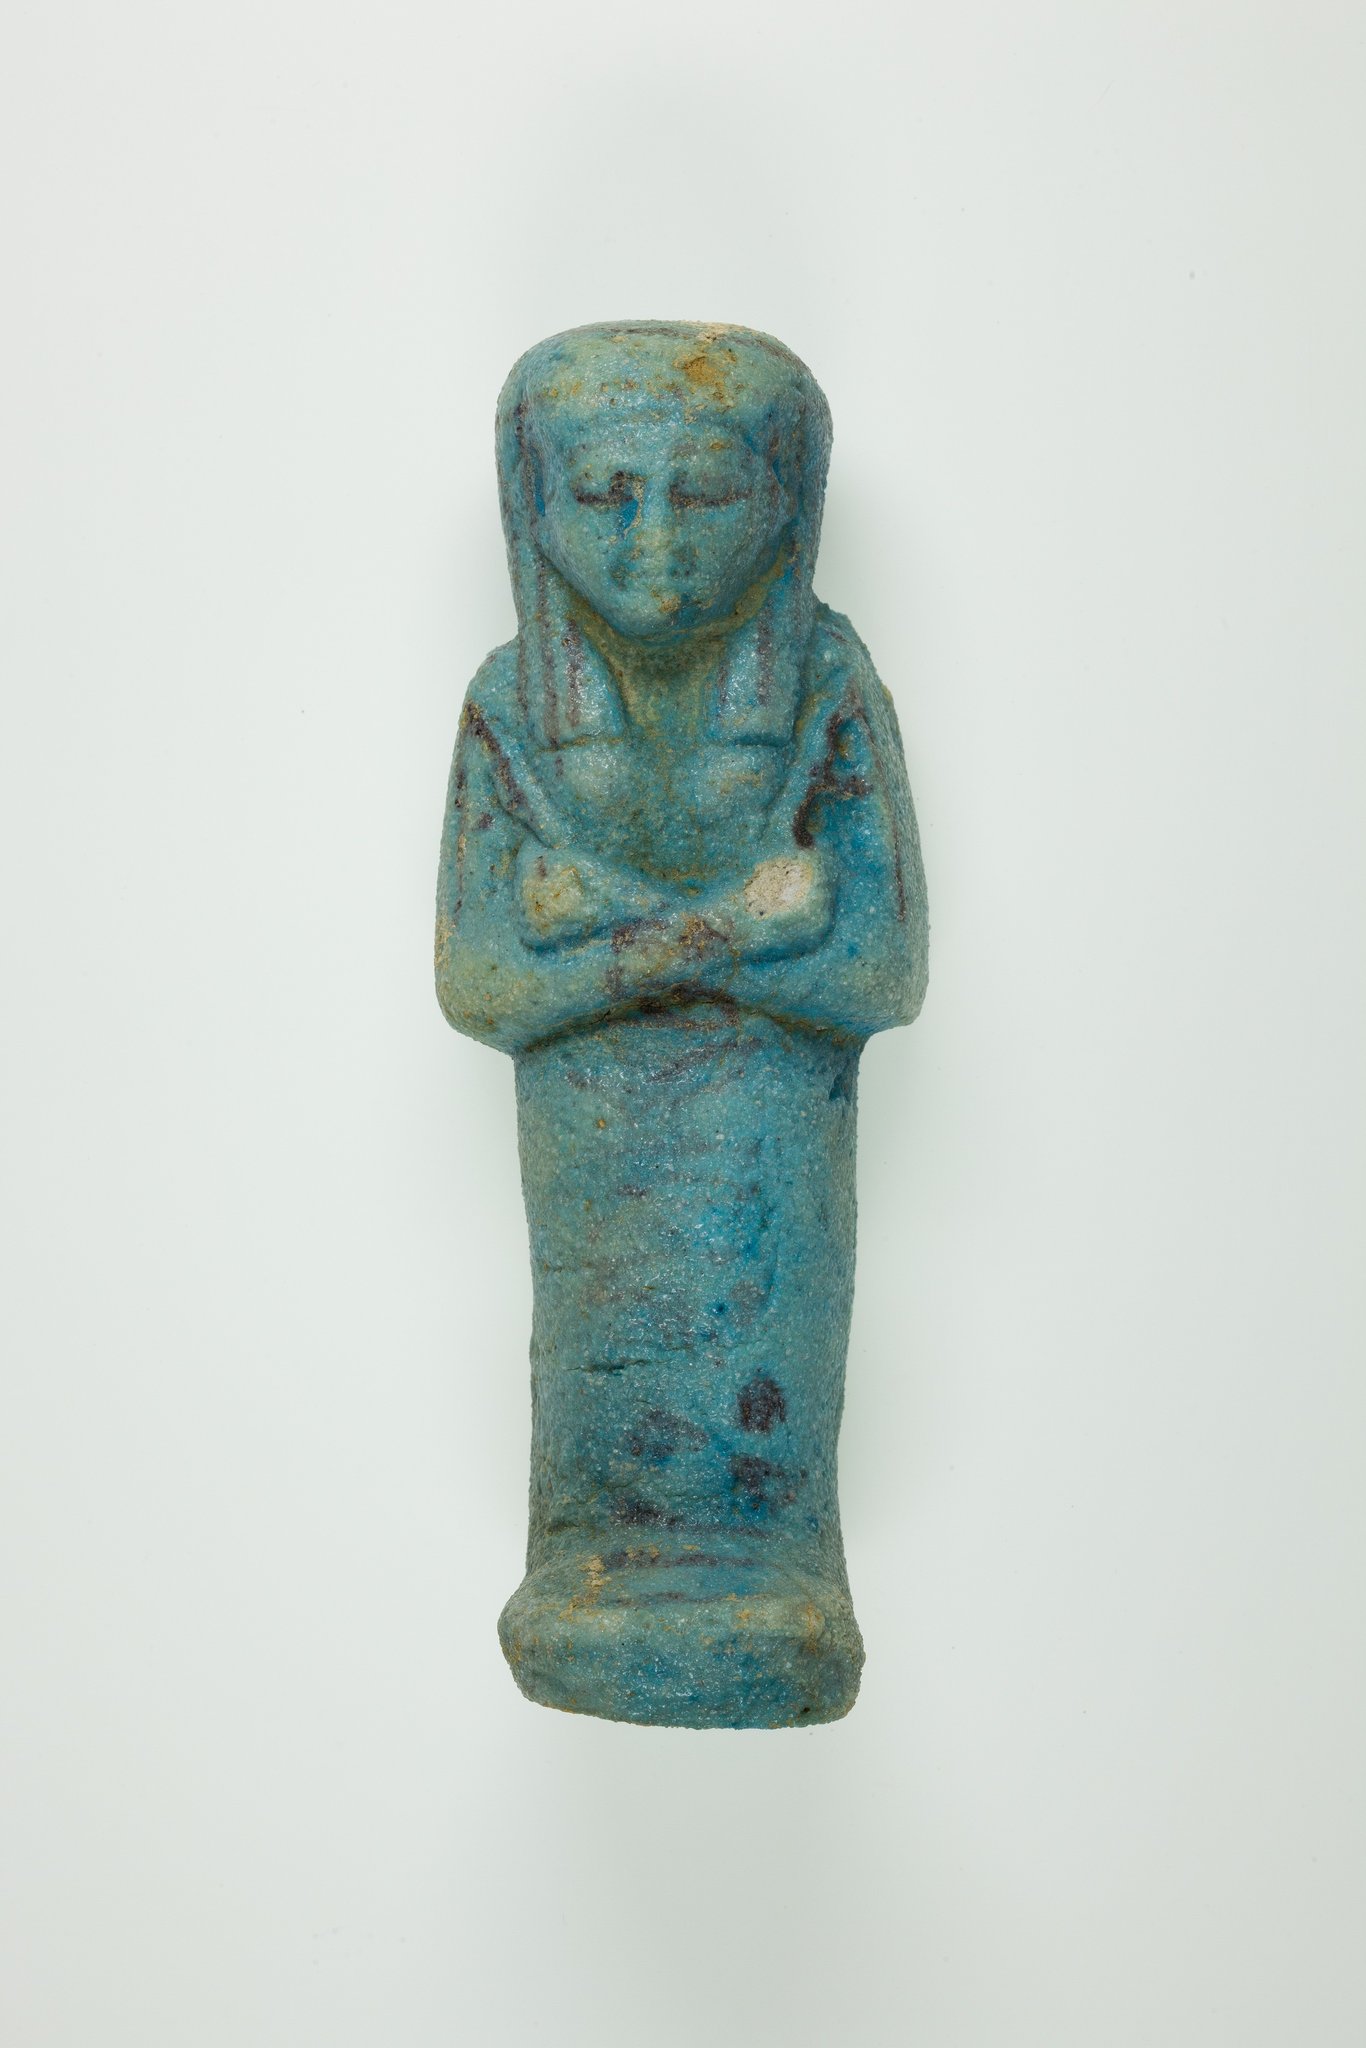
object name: worker shabti, henettawy c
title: Worker Shabti of Henettawy (C), Daughter of Isetemkheb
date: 990-970 BCE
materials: faience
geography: egypt